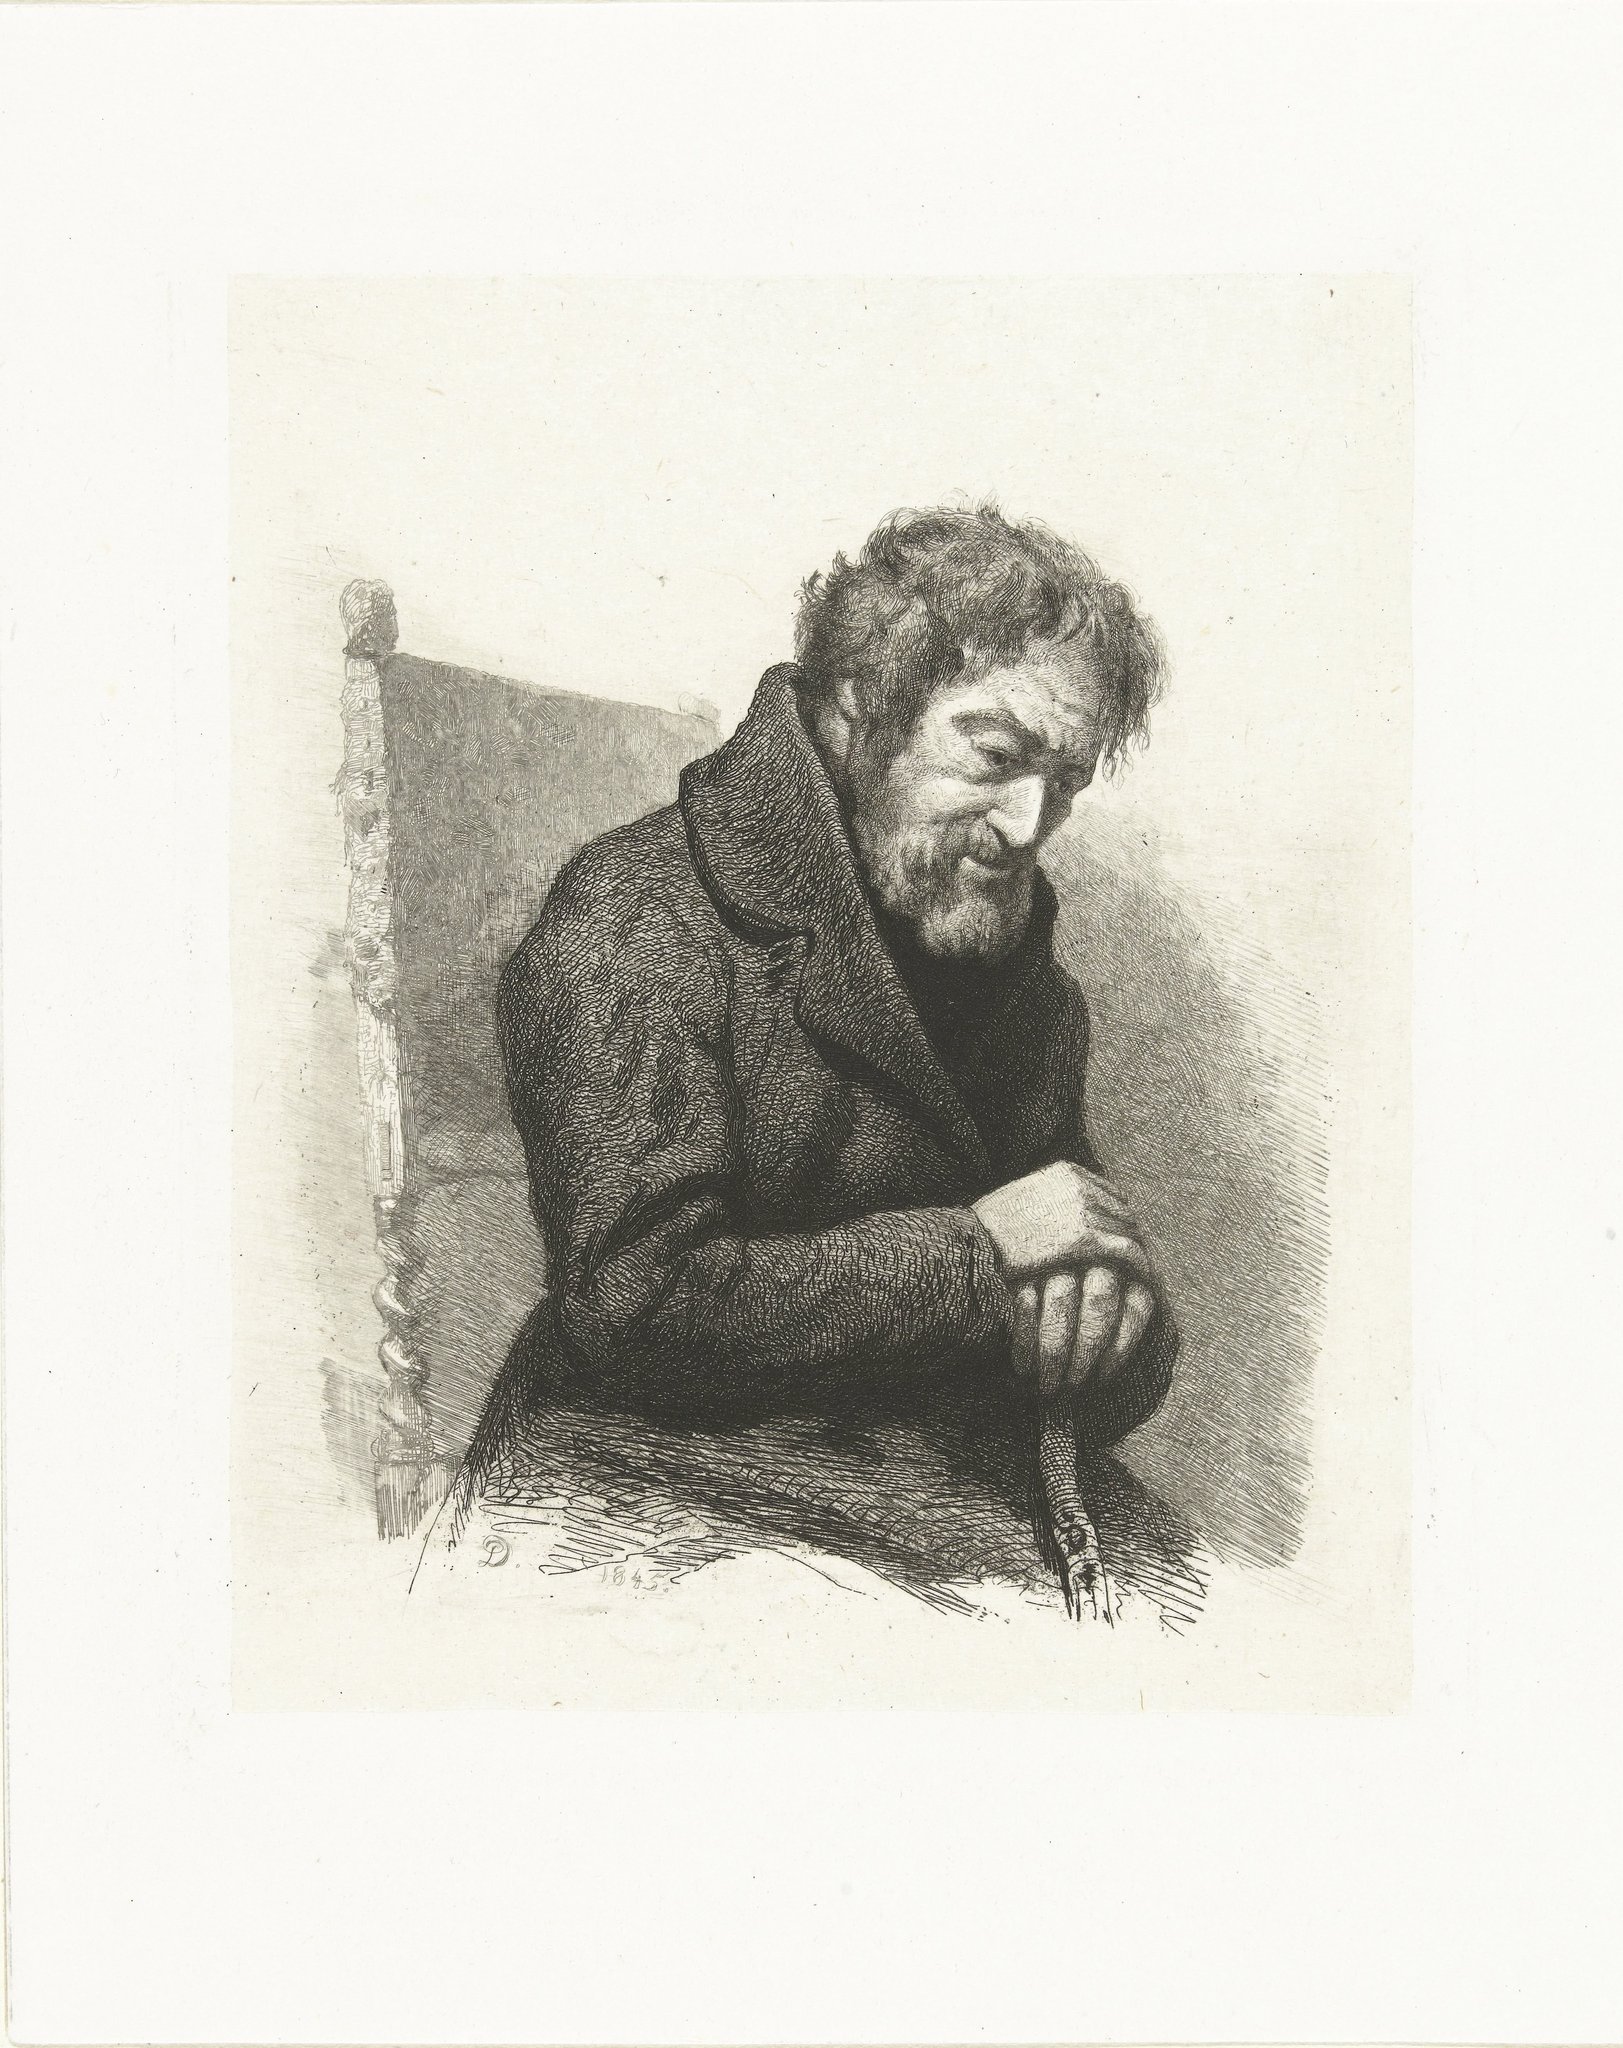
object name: print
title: Zittende grijsaard met wandelstok in zijn handen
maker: pierre louis dubourcq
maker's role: draughtsman, painter, print maker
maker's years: 1815-1873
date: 1845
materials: paper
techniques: aquatint, etching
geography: netherlands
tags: old man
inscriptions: collector's mark: Lugt 2228, collector's mark: Lugt 2760